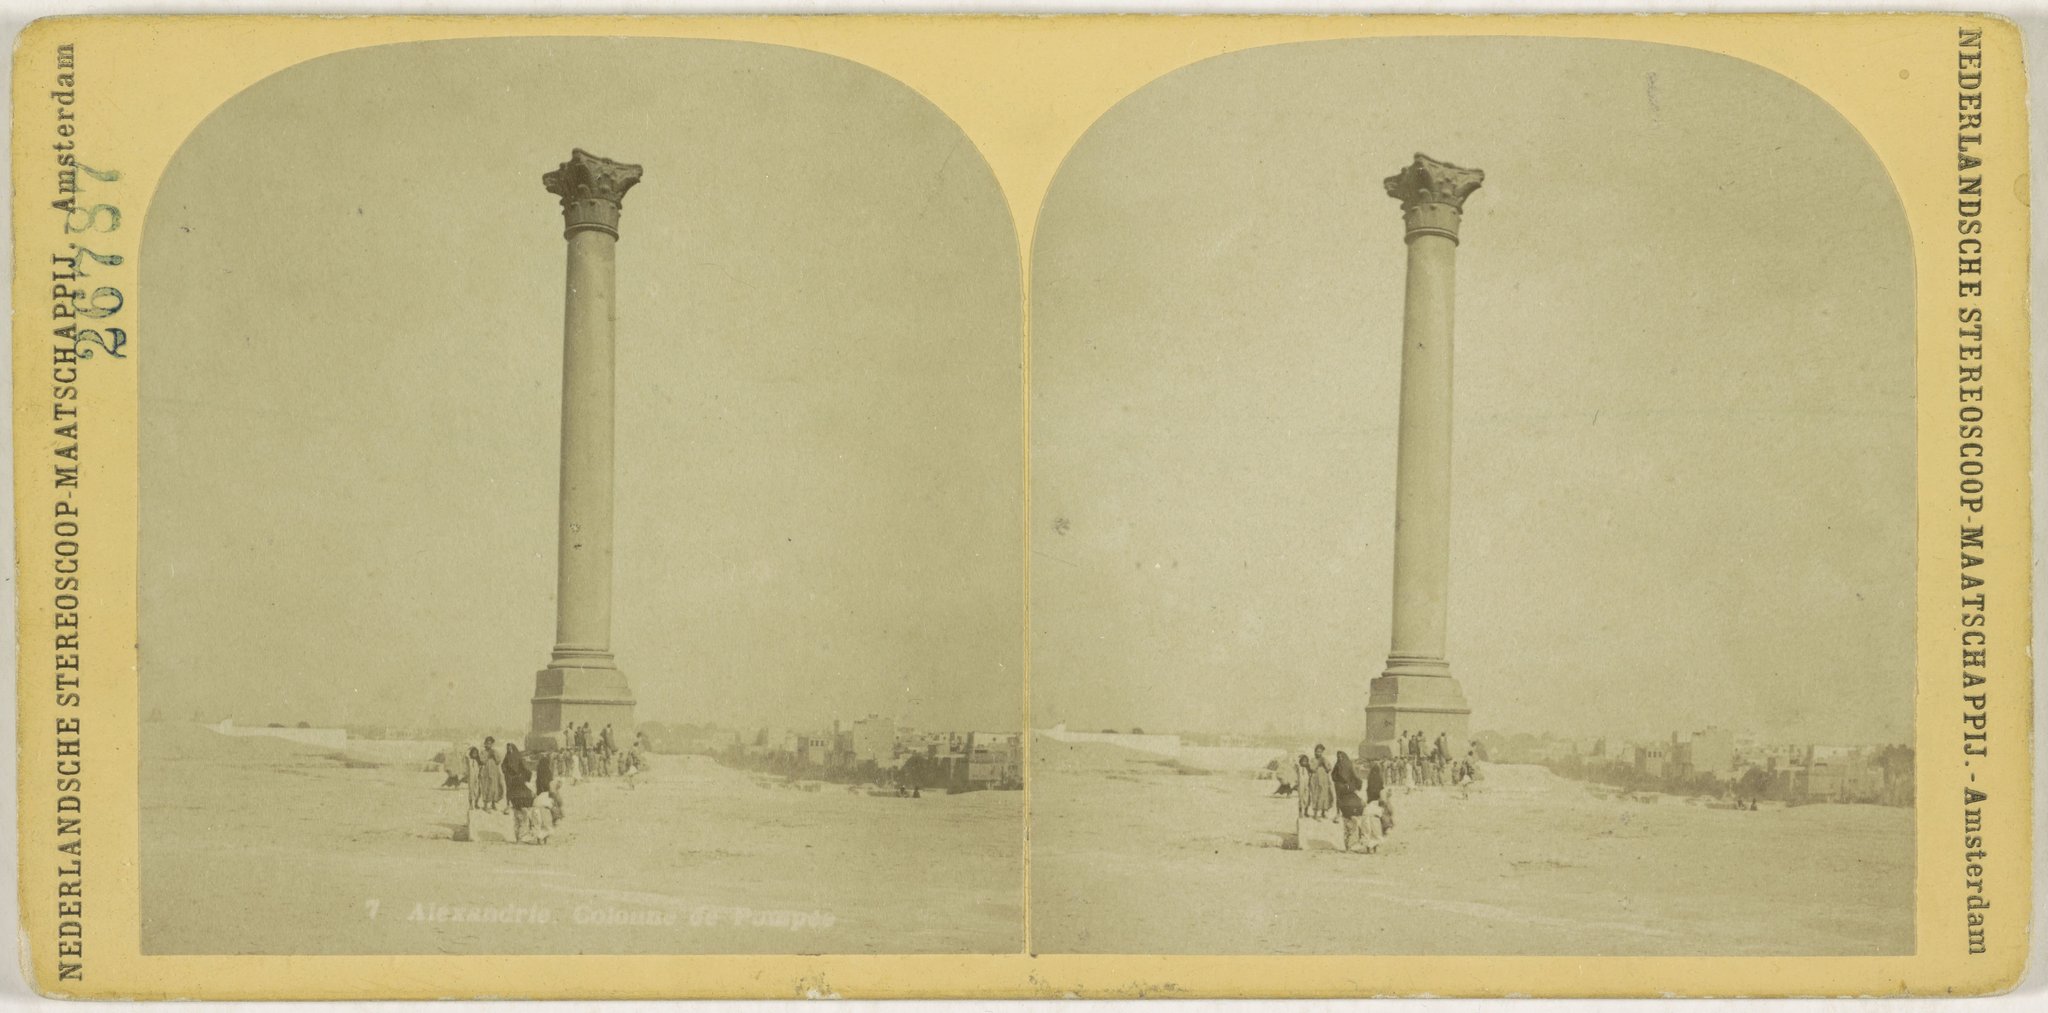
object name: stereograph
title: Alexandrie. Colonne de Pompée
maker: j.g. beers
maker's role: fotograaf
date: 1873-1890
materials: cardboard, paper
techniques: albumen print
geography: amsterdam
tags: column, pillar ~ architecture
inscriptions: number: ‘26787’, number: ‘7’